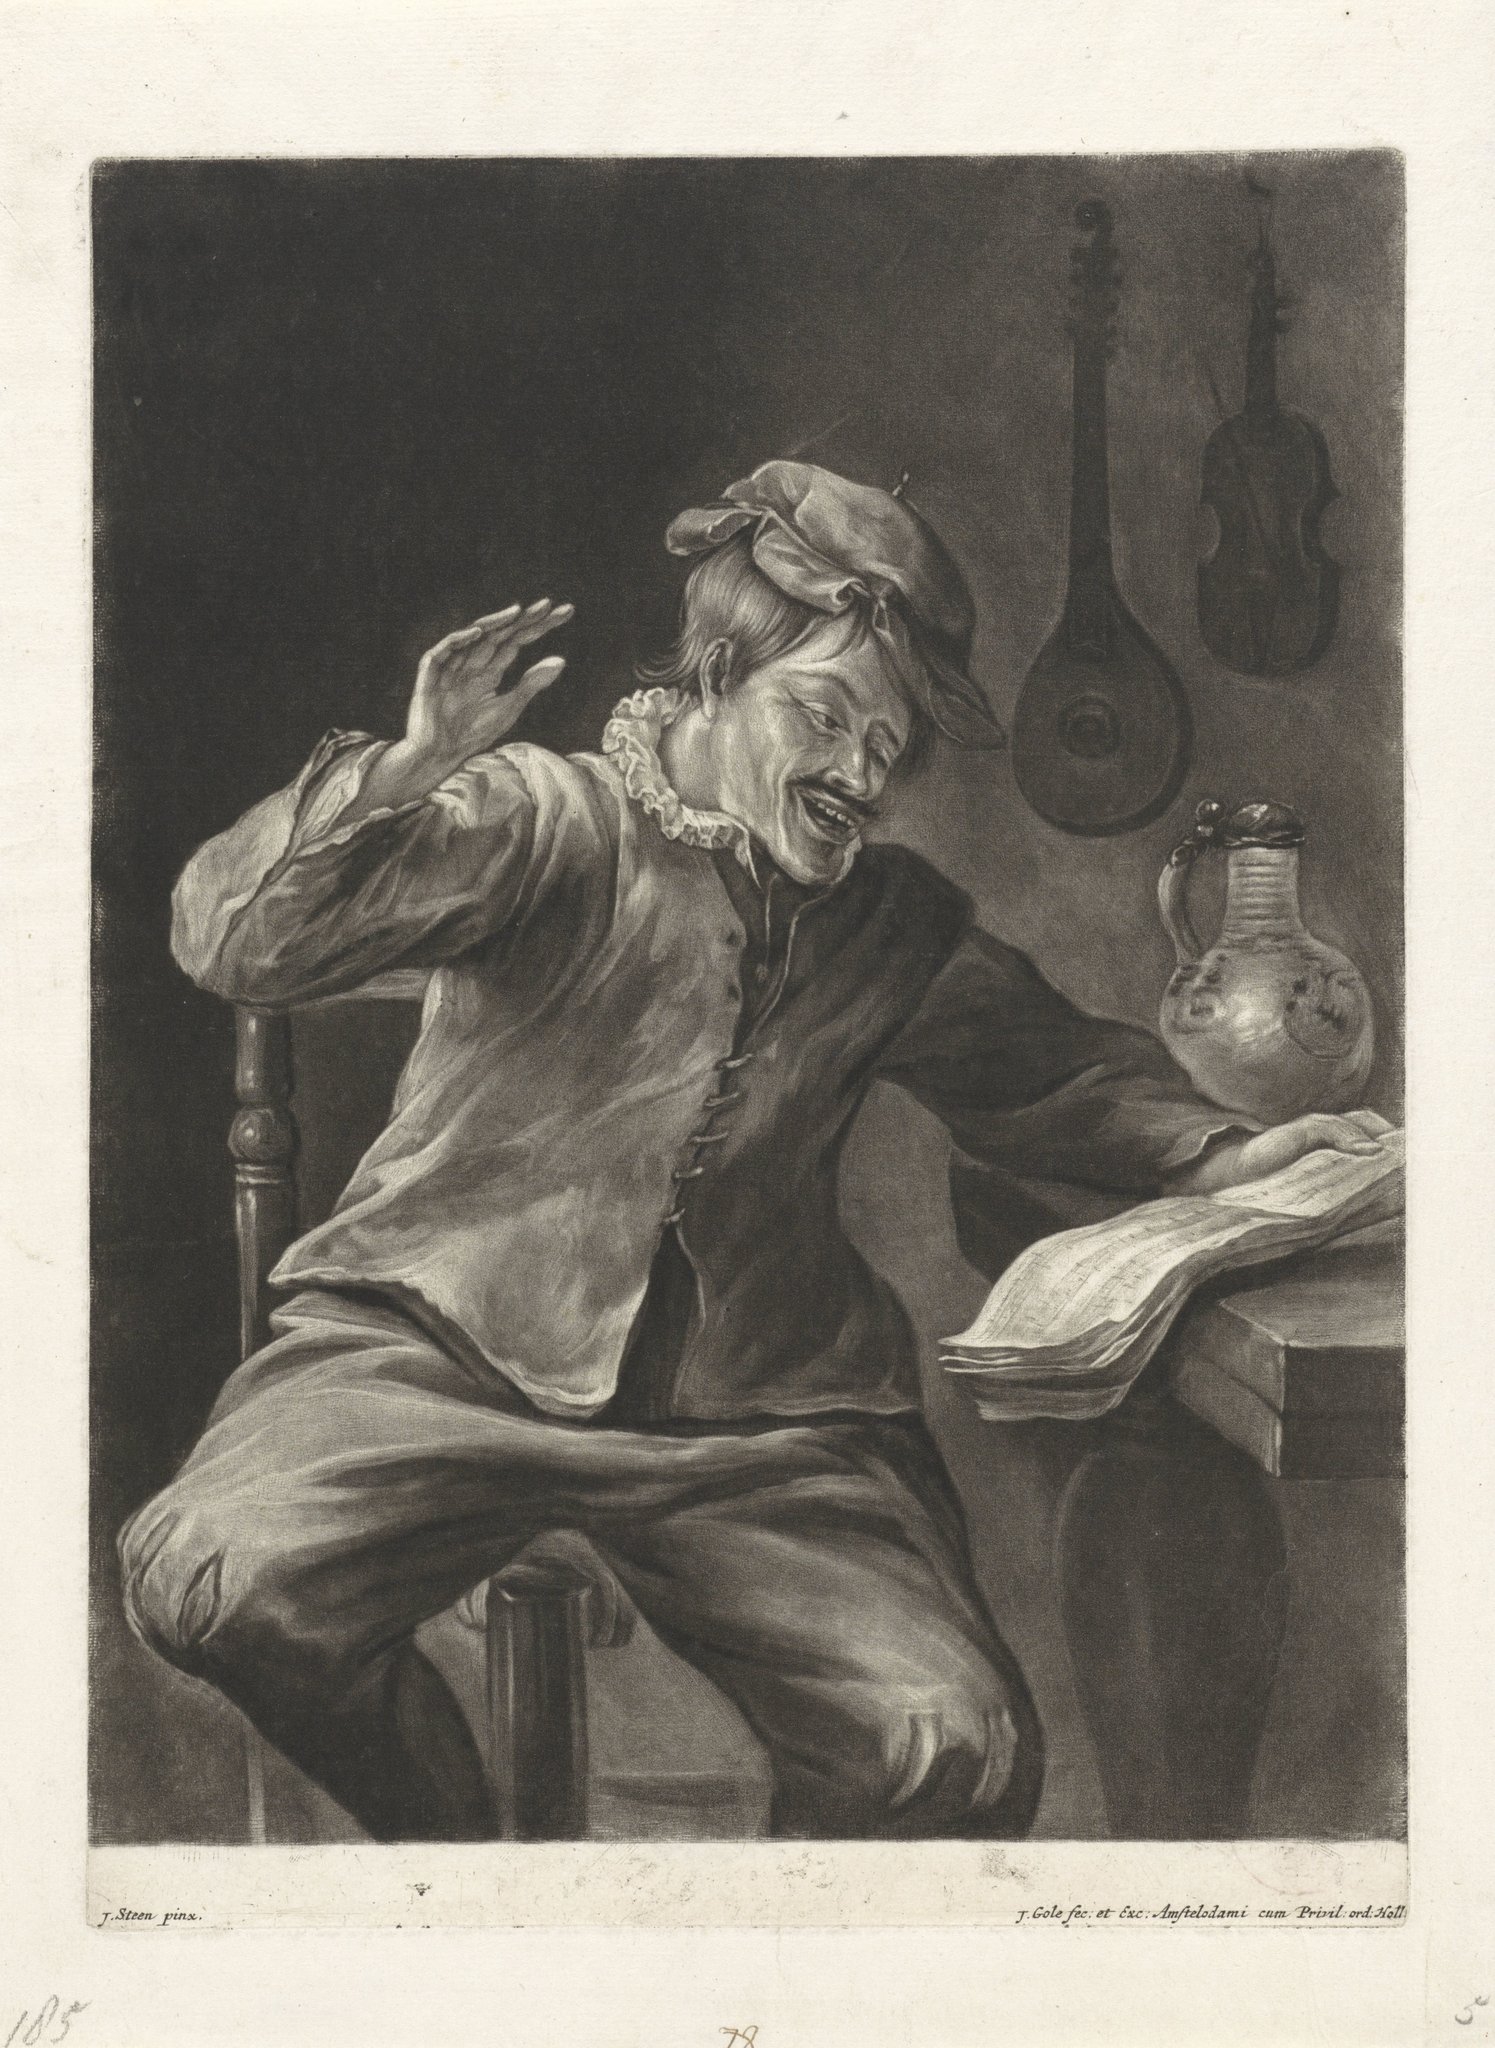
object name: print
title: De vijf zintuigen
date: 1670-1724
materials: paper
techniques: engraving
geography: amsterdam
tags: hearing, listening (one of the five senses), violin, fiddle, vocal music, singing, lute, and special forms of lute, e.g.: theorbo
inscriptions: collector's mark: Lugt 240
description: Het Gehoor. Een zingende man met bladmuziek. Aan de muur hangen een luit en een viool. De prent maakt deel uit van een serie met de vijf zintuigen.